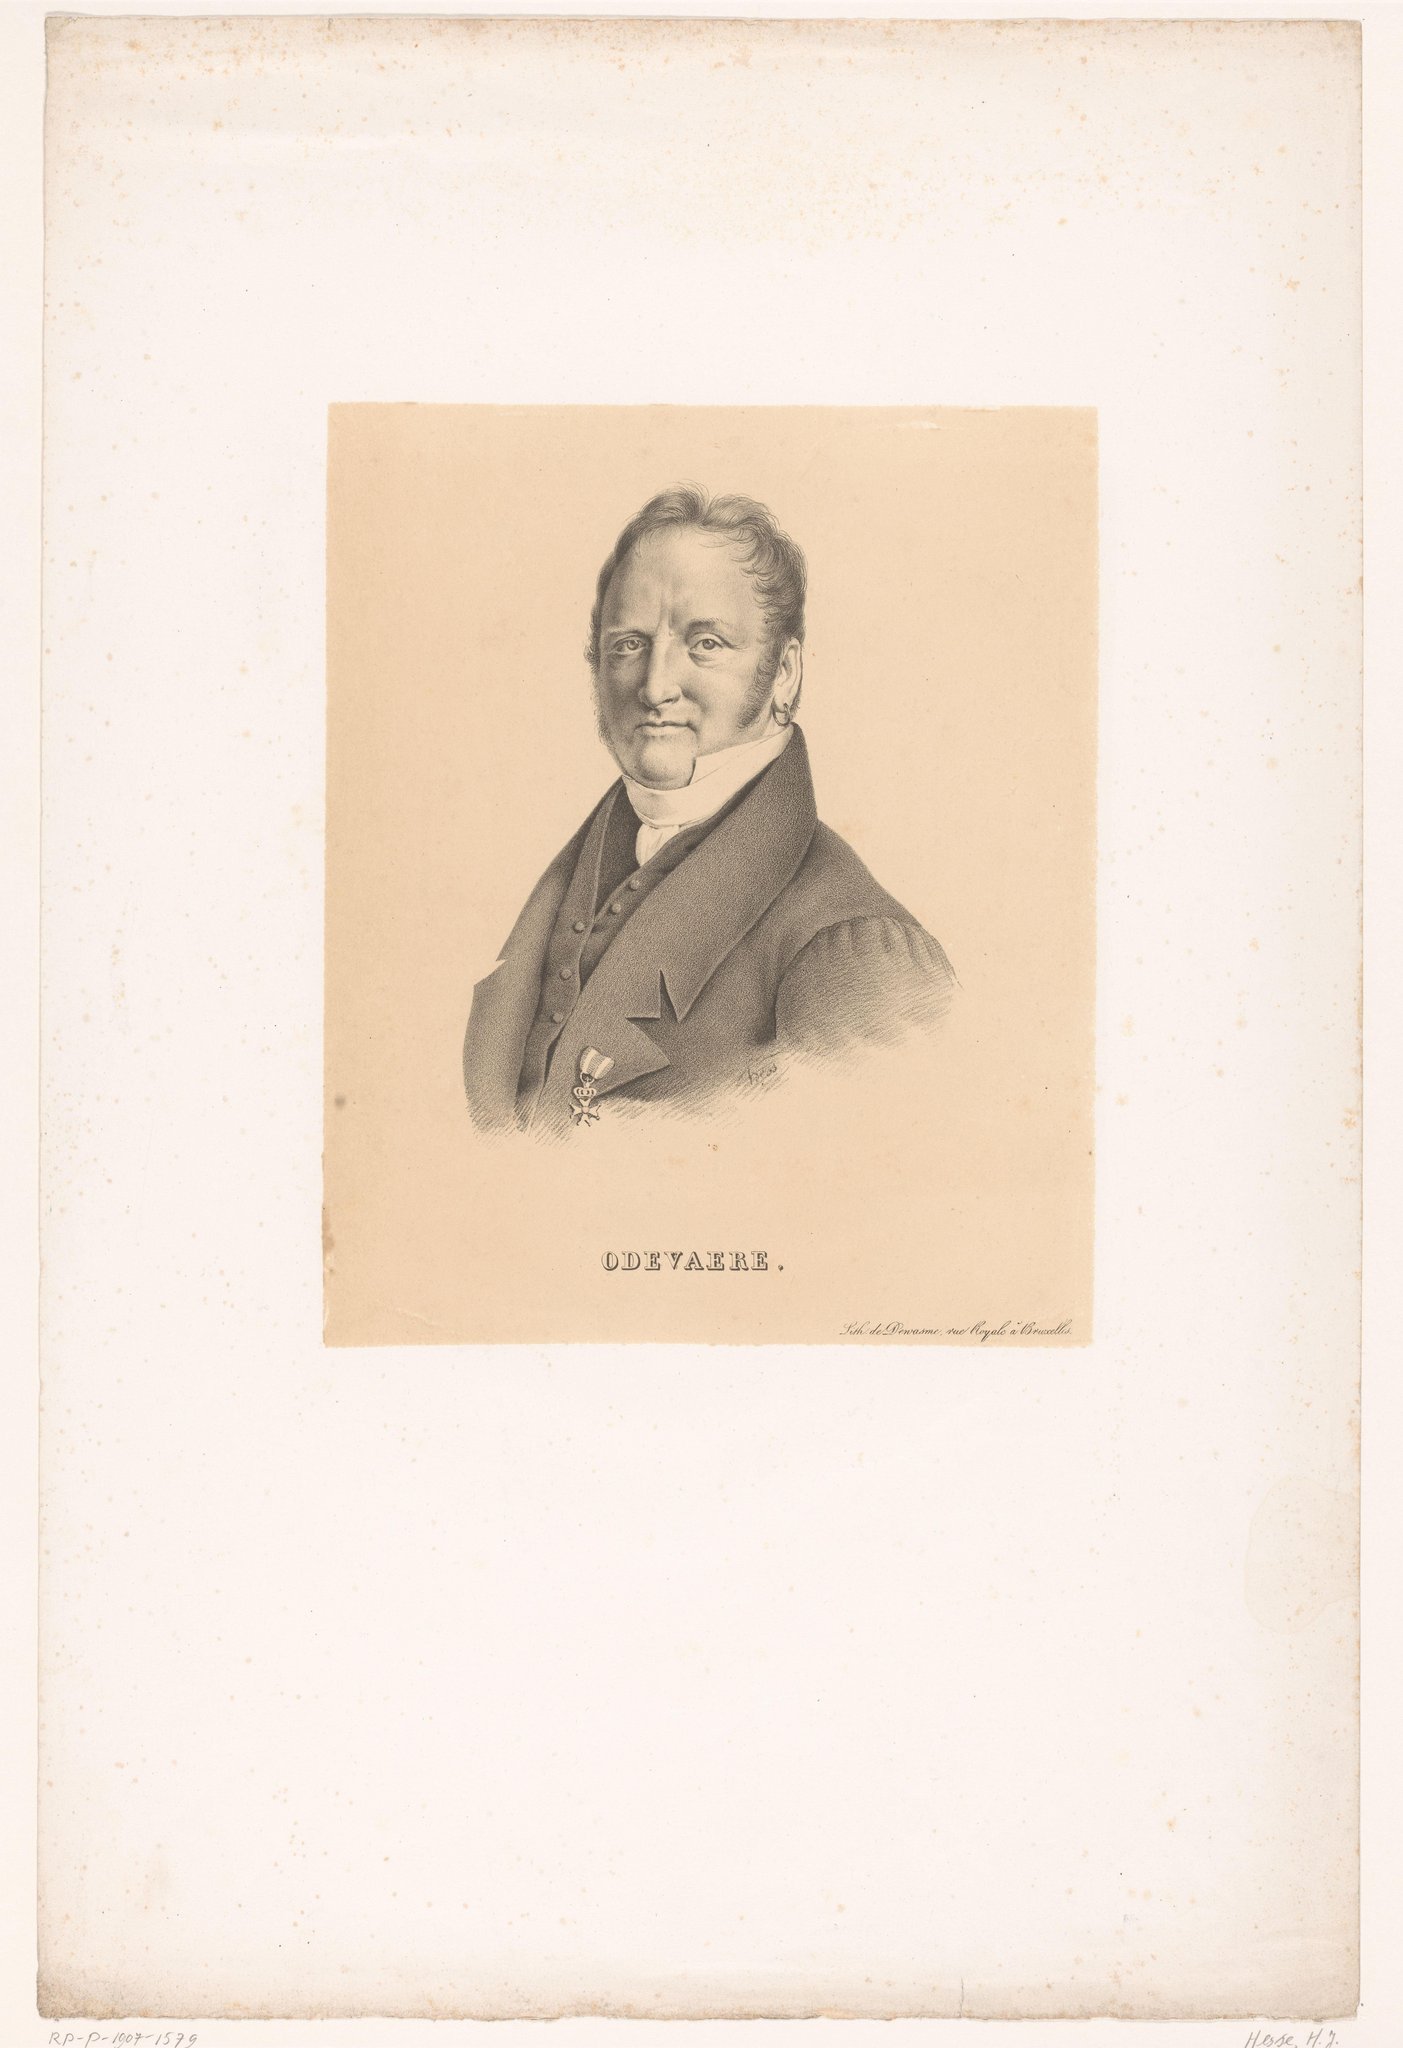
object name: print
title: Odevaere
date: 1822-1832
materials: paper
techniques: lithograph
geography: brussels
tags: brussels, painter, print maker, joseph-denis odevaere, historical persons, portrait, self-portrait of painter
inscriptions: collector's mark: Lugt 2228a